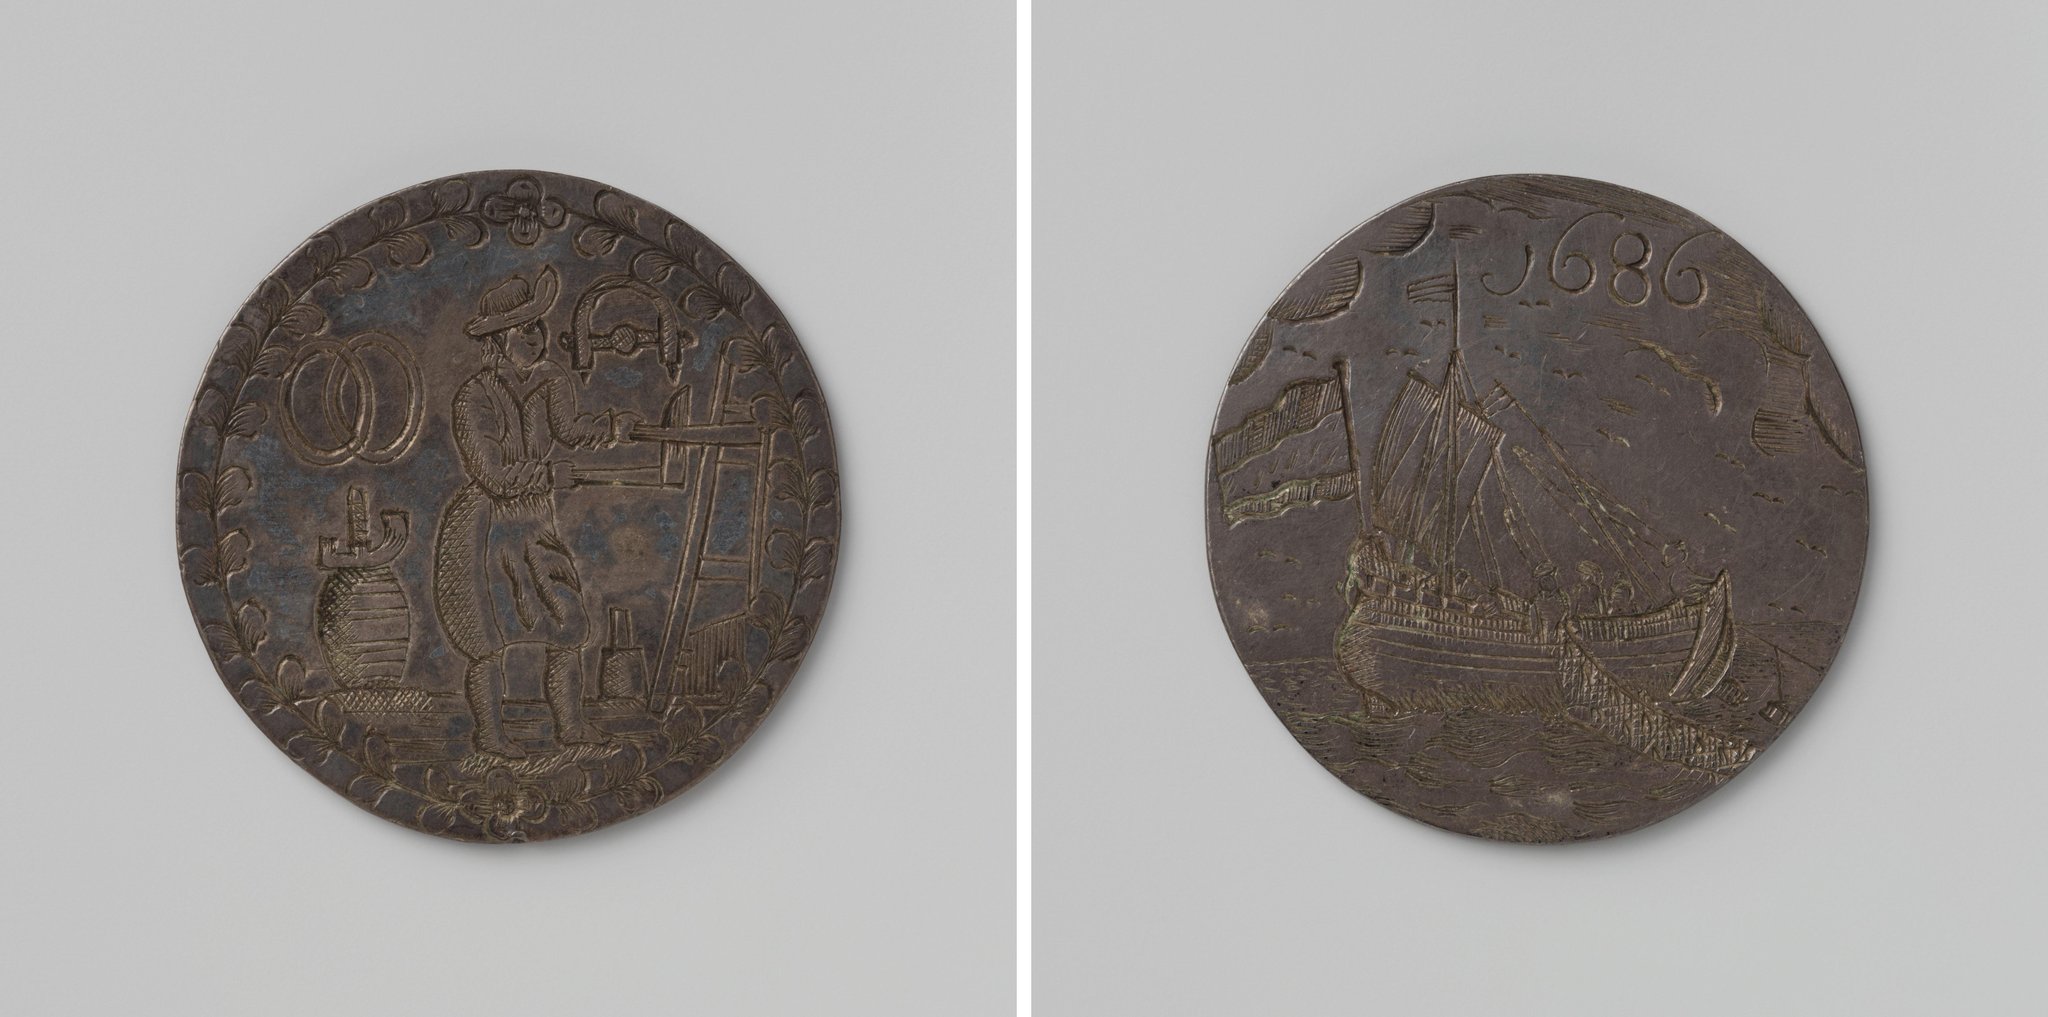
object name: medal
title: Kuipersgilde van Enkhuizen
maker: Anonymous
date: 1686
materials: silver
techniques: engraving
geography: enkhuizen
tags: enkhuizen